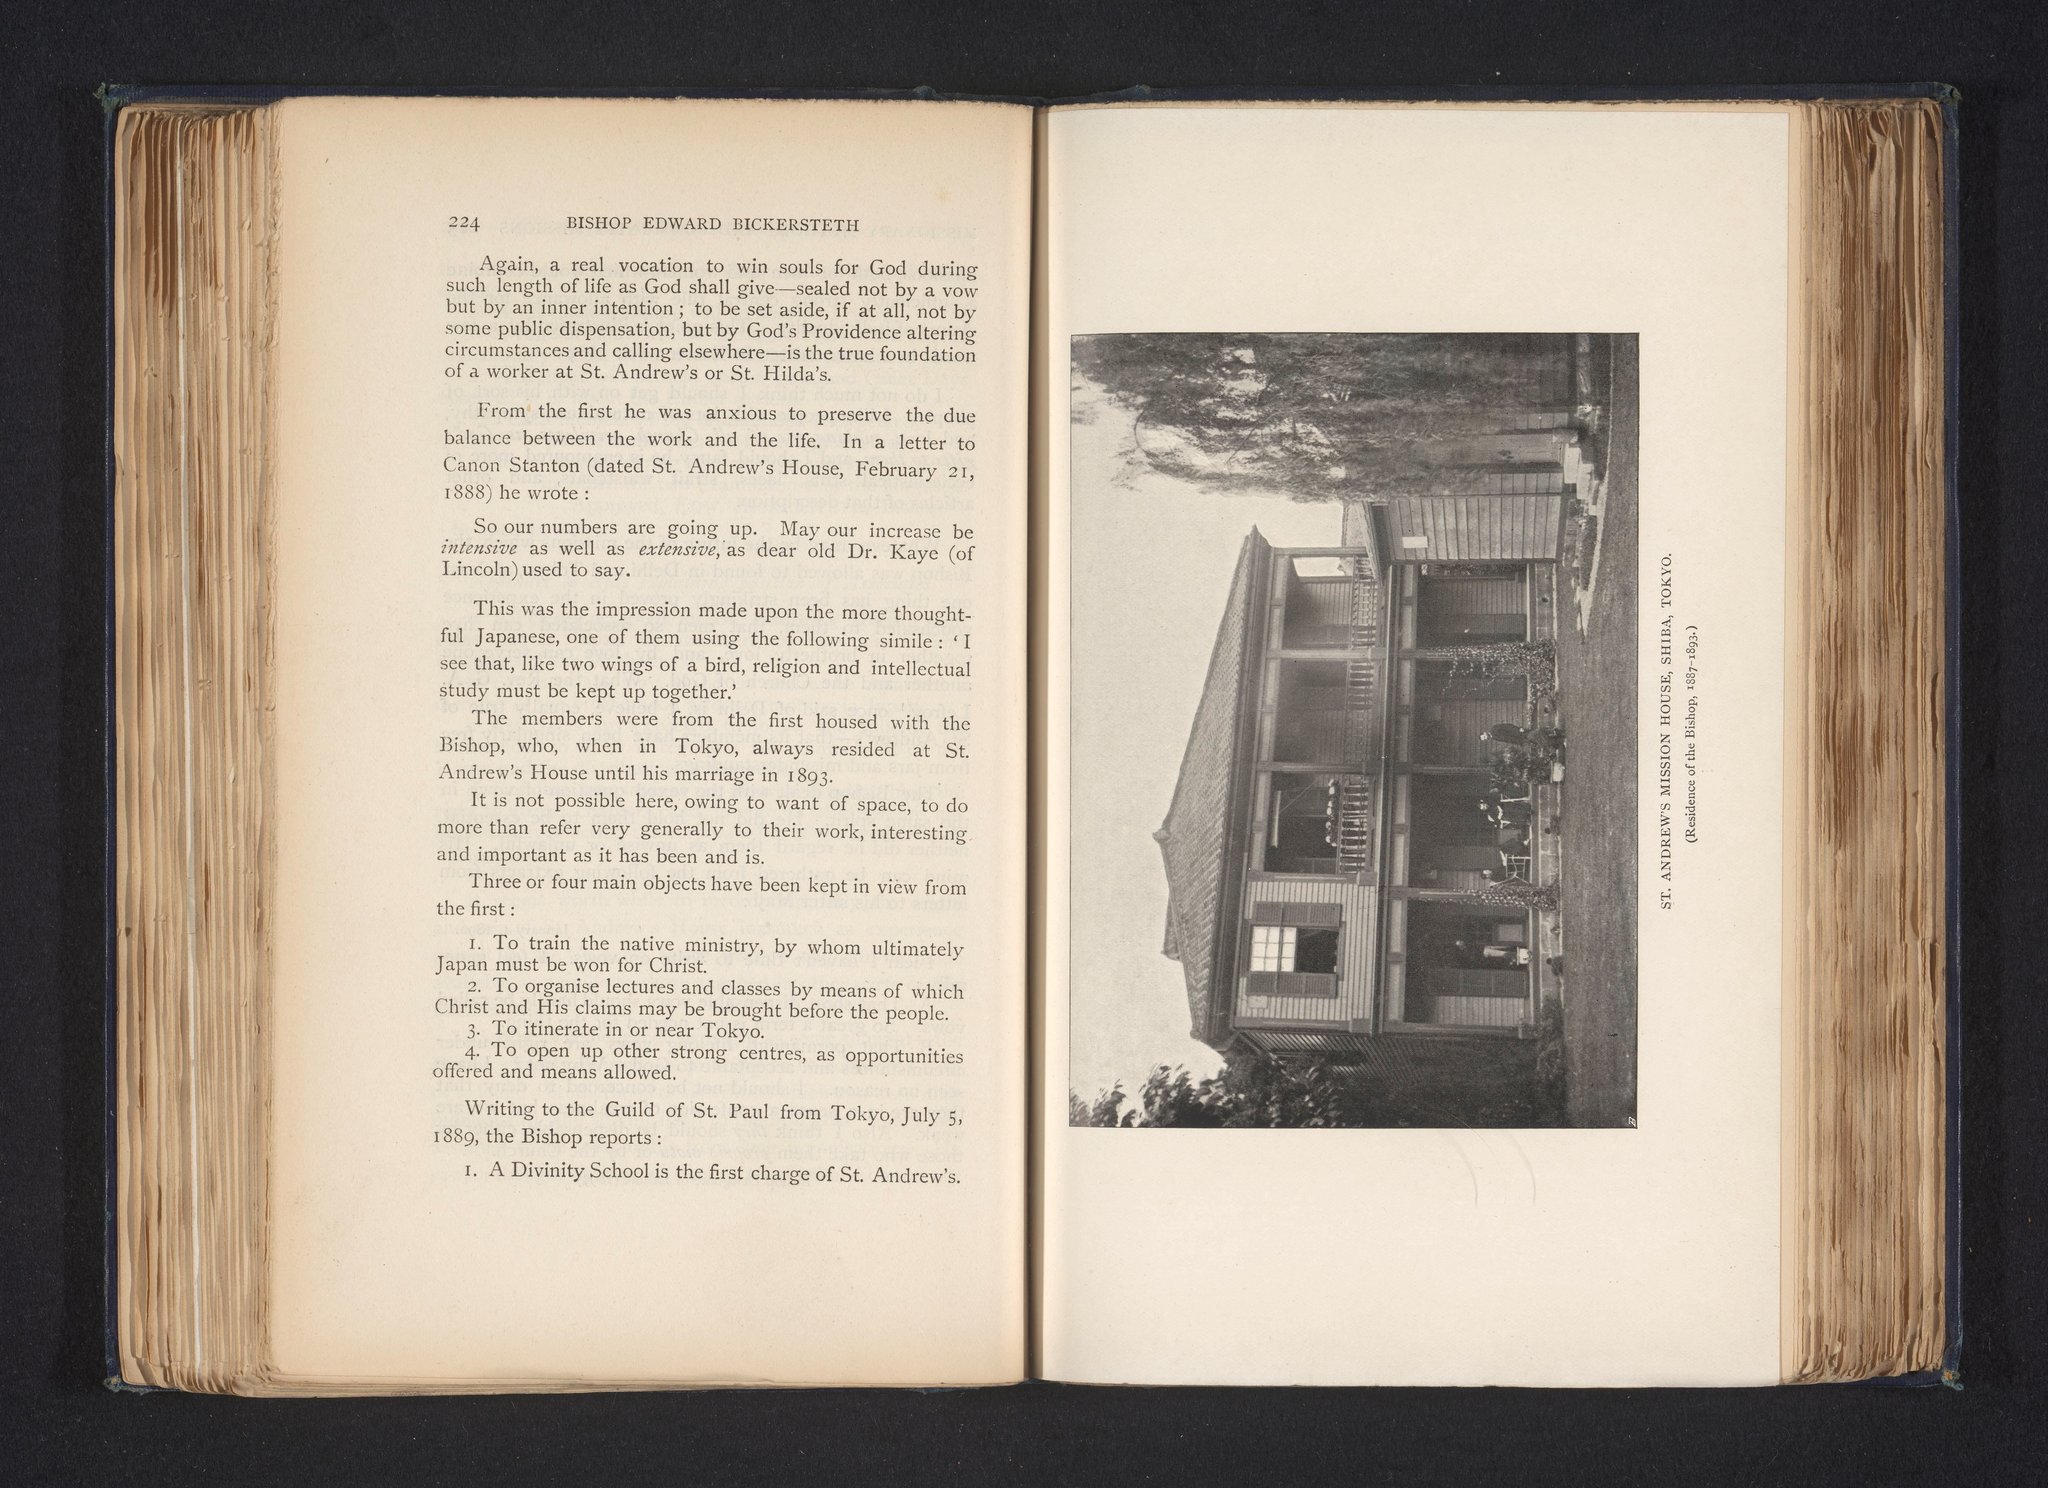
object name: page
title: St. Andrew's mission house, Shiba, Tokyo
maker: Anonymous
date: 1889-1899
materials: paper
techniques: autotype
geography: tokyo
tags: façade (of house or building), spreading the gospel; missionary work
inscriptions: inscription: ‘(Residence of the Bishop, 1887-1893.)’